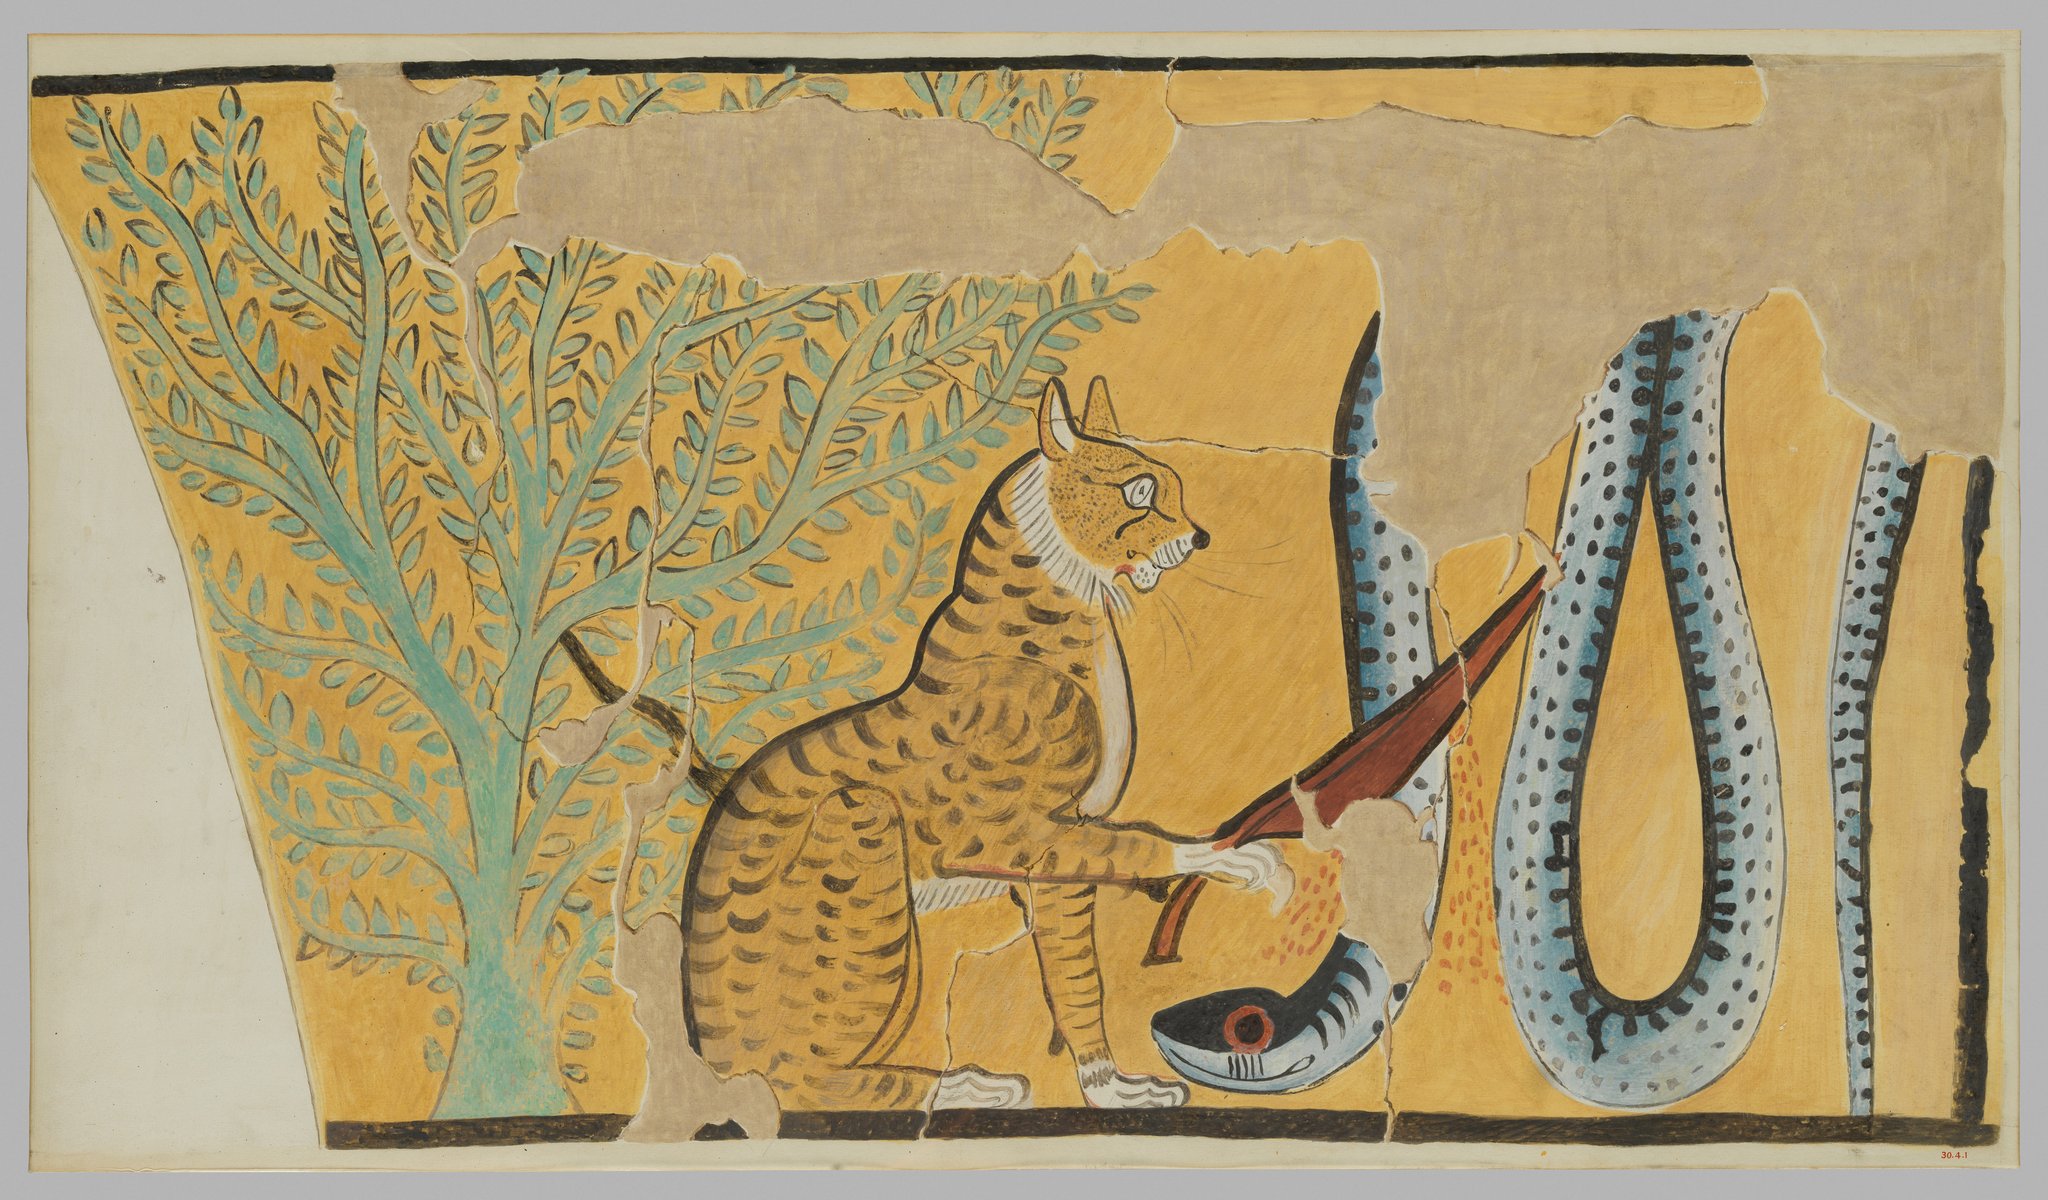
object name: facsimile, sennedjem, tt 1, cat, serpent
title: Wall painting of a cat killing a serpent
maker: charles k. wilkinson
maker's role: artist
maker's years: 1897-1986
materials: paper, paint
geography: africa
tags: cats,serpents